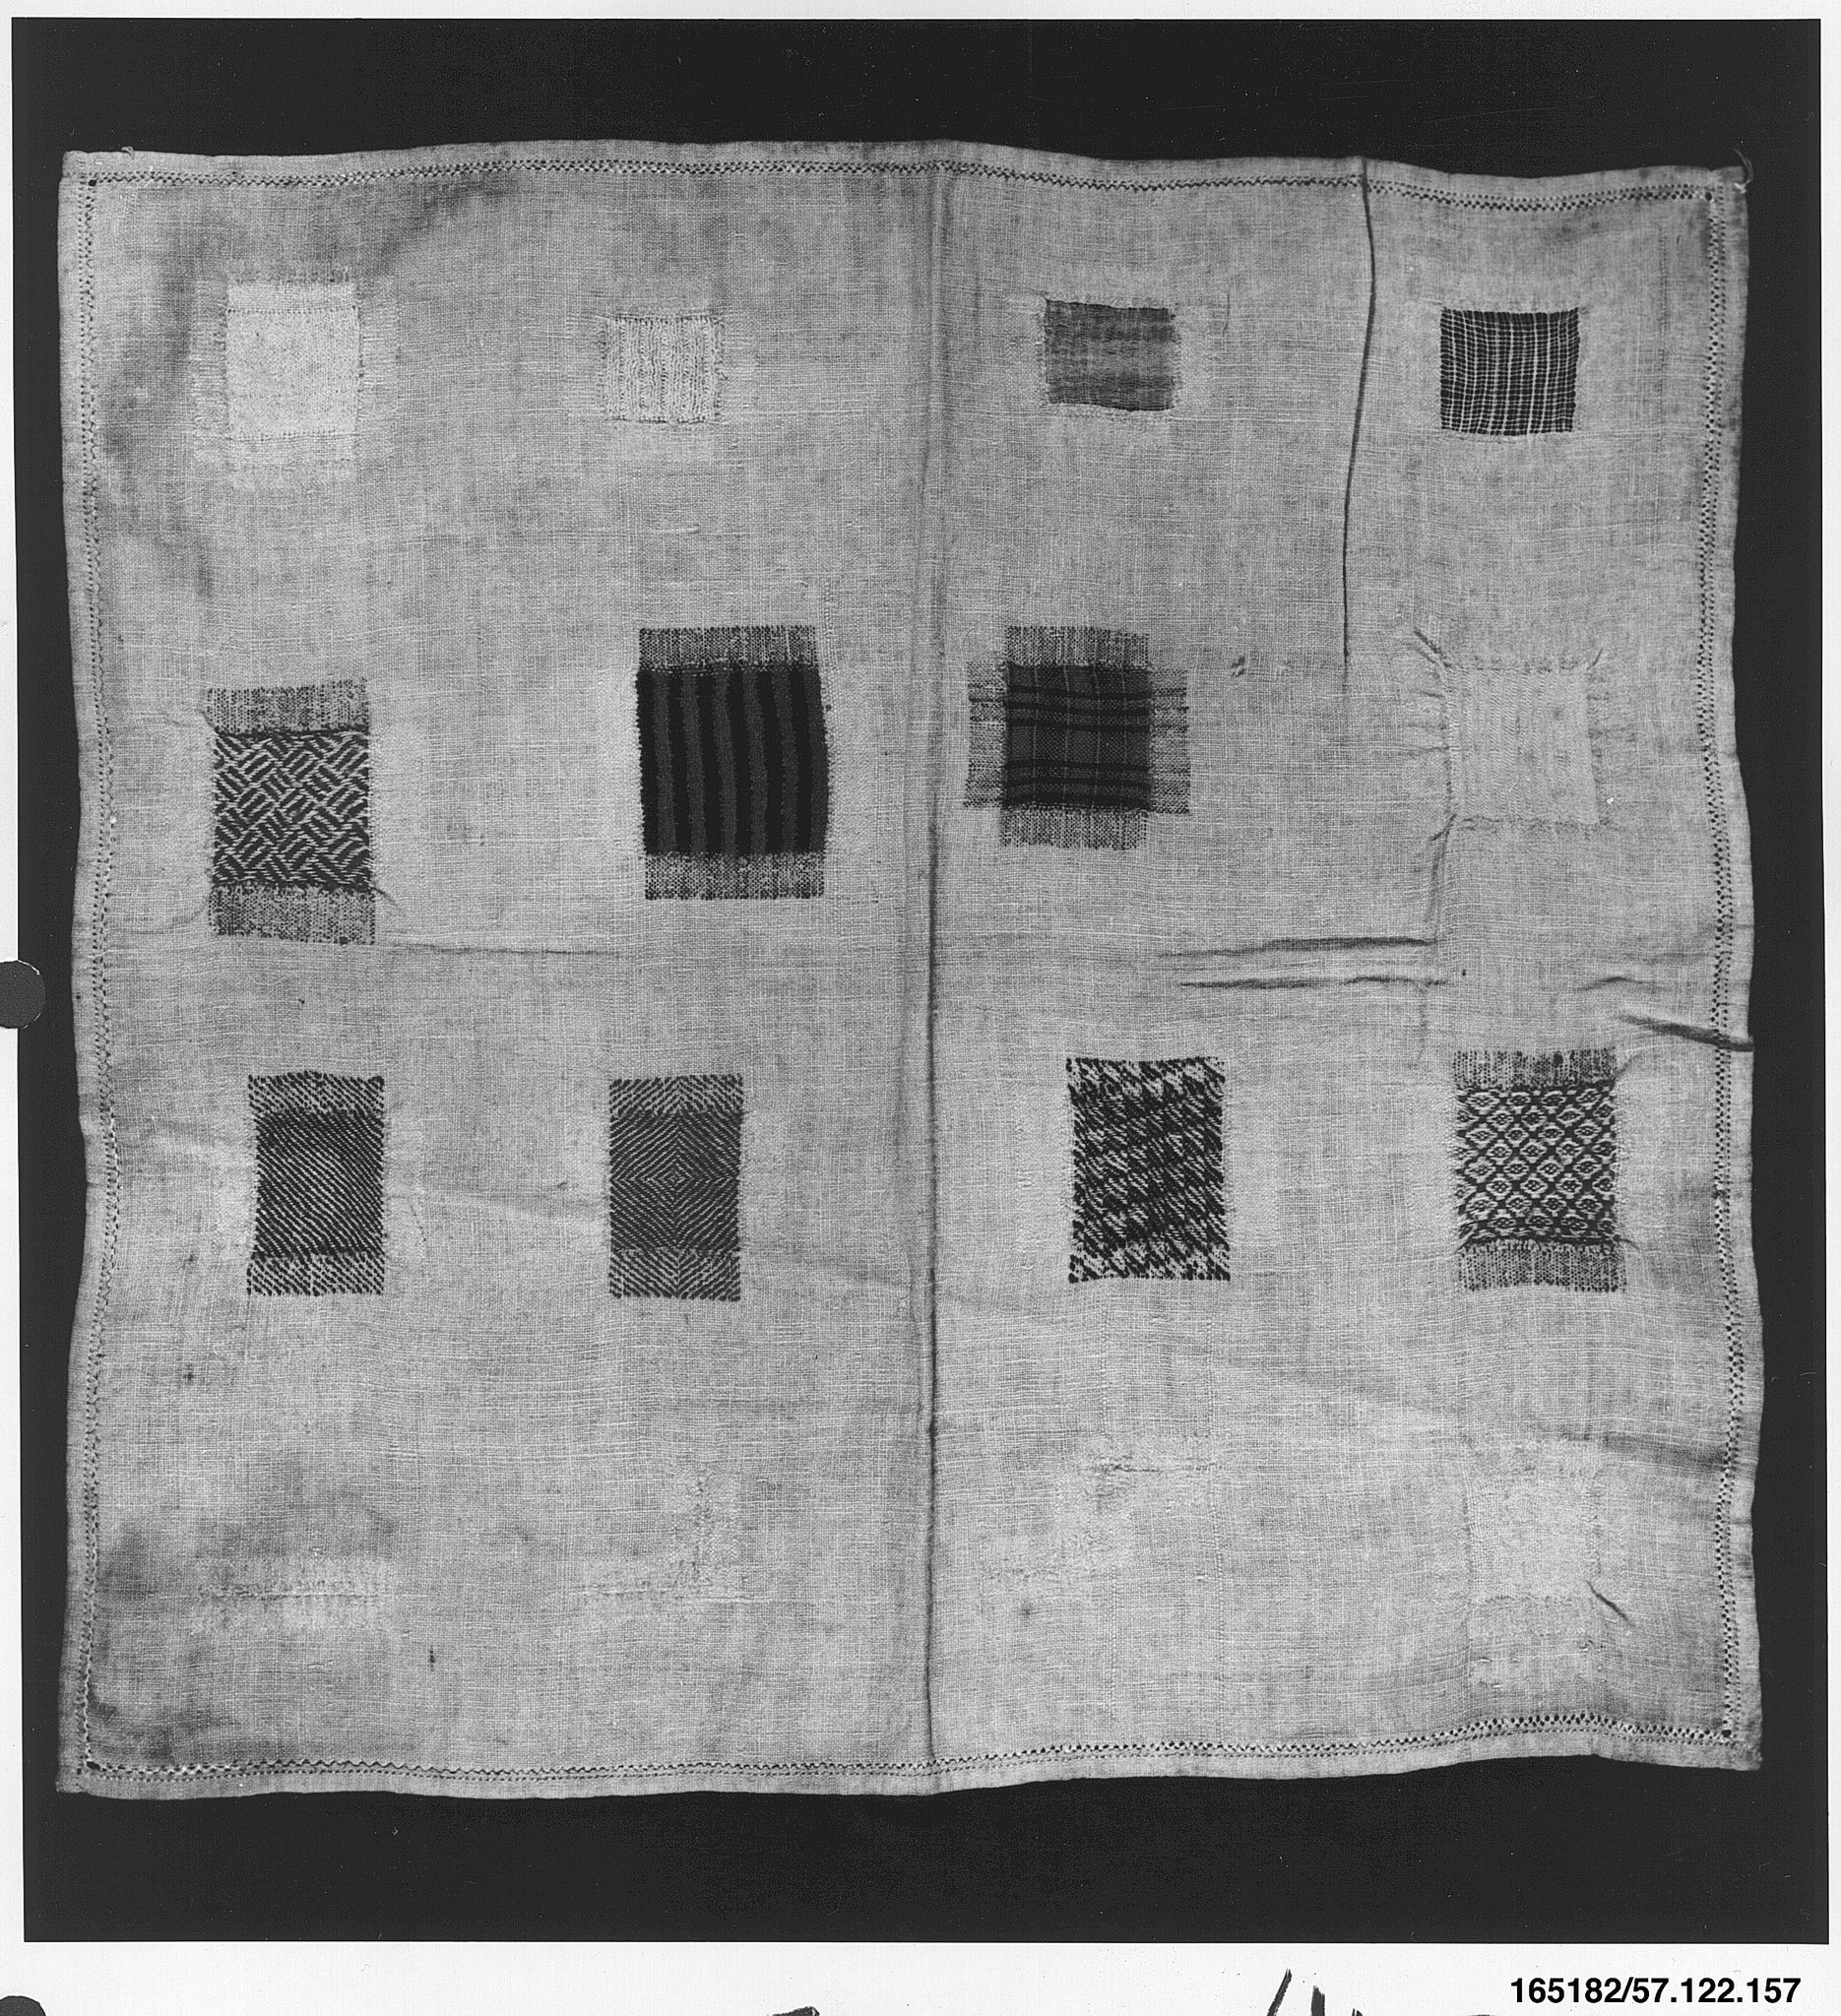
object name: sampler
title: Embroidered darning sampler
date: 1801-1900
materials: cotton